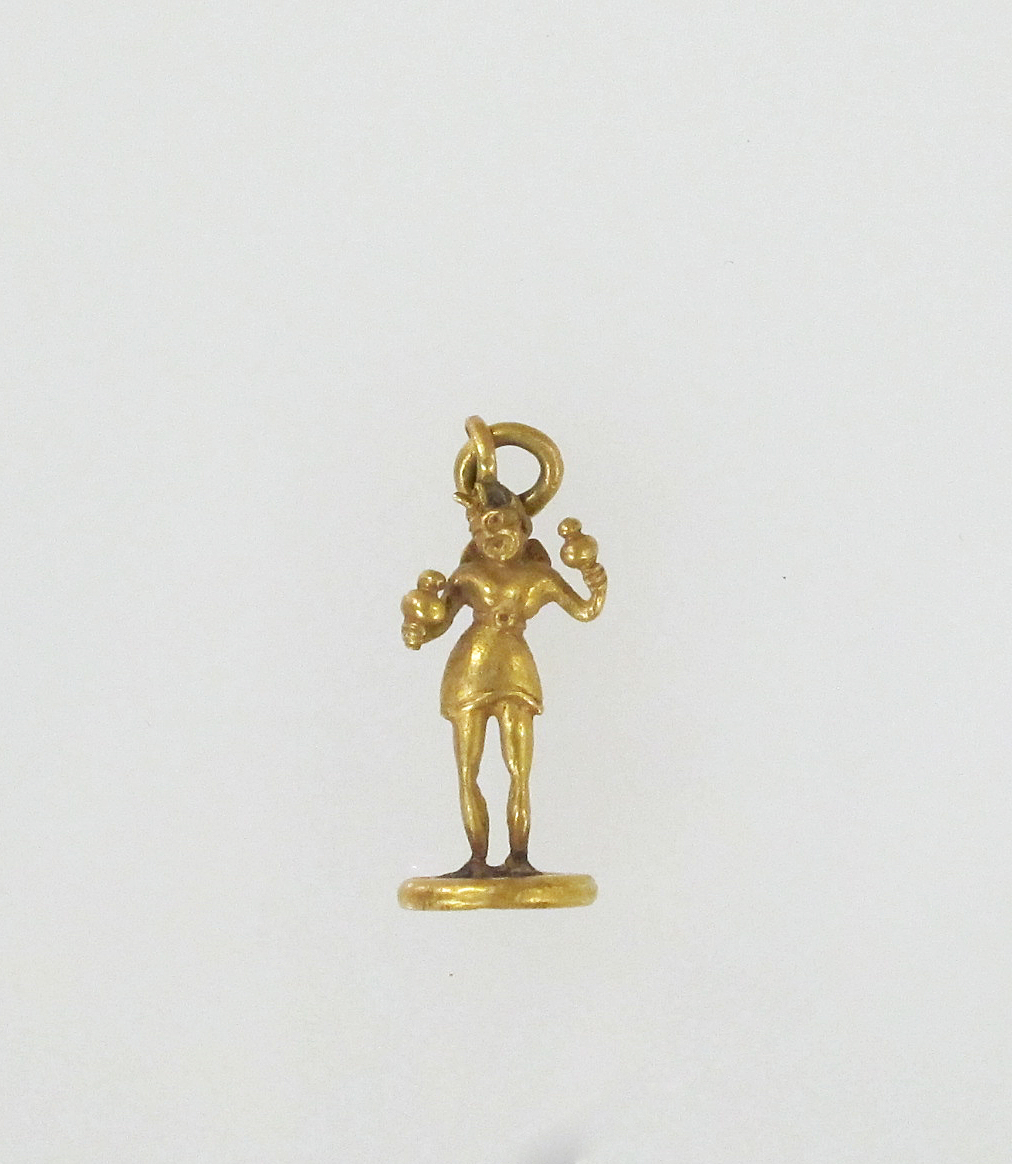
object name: pendant in the form of an actor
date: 7000 BCE-330 CE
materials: gold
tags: human figures,actors